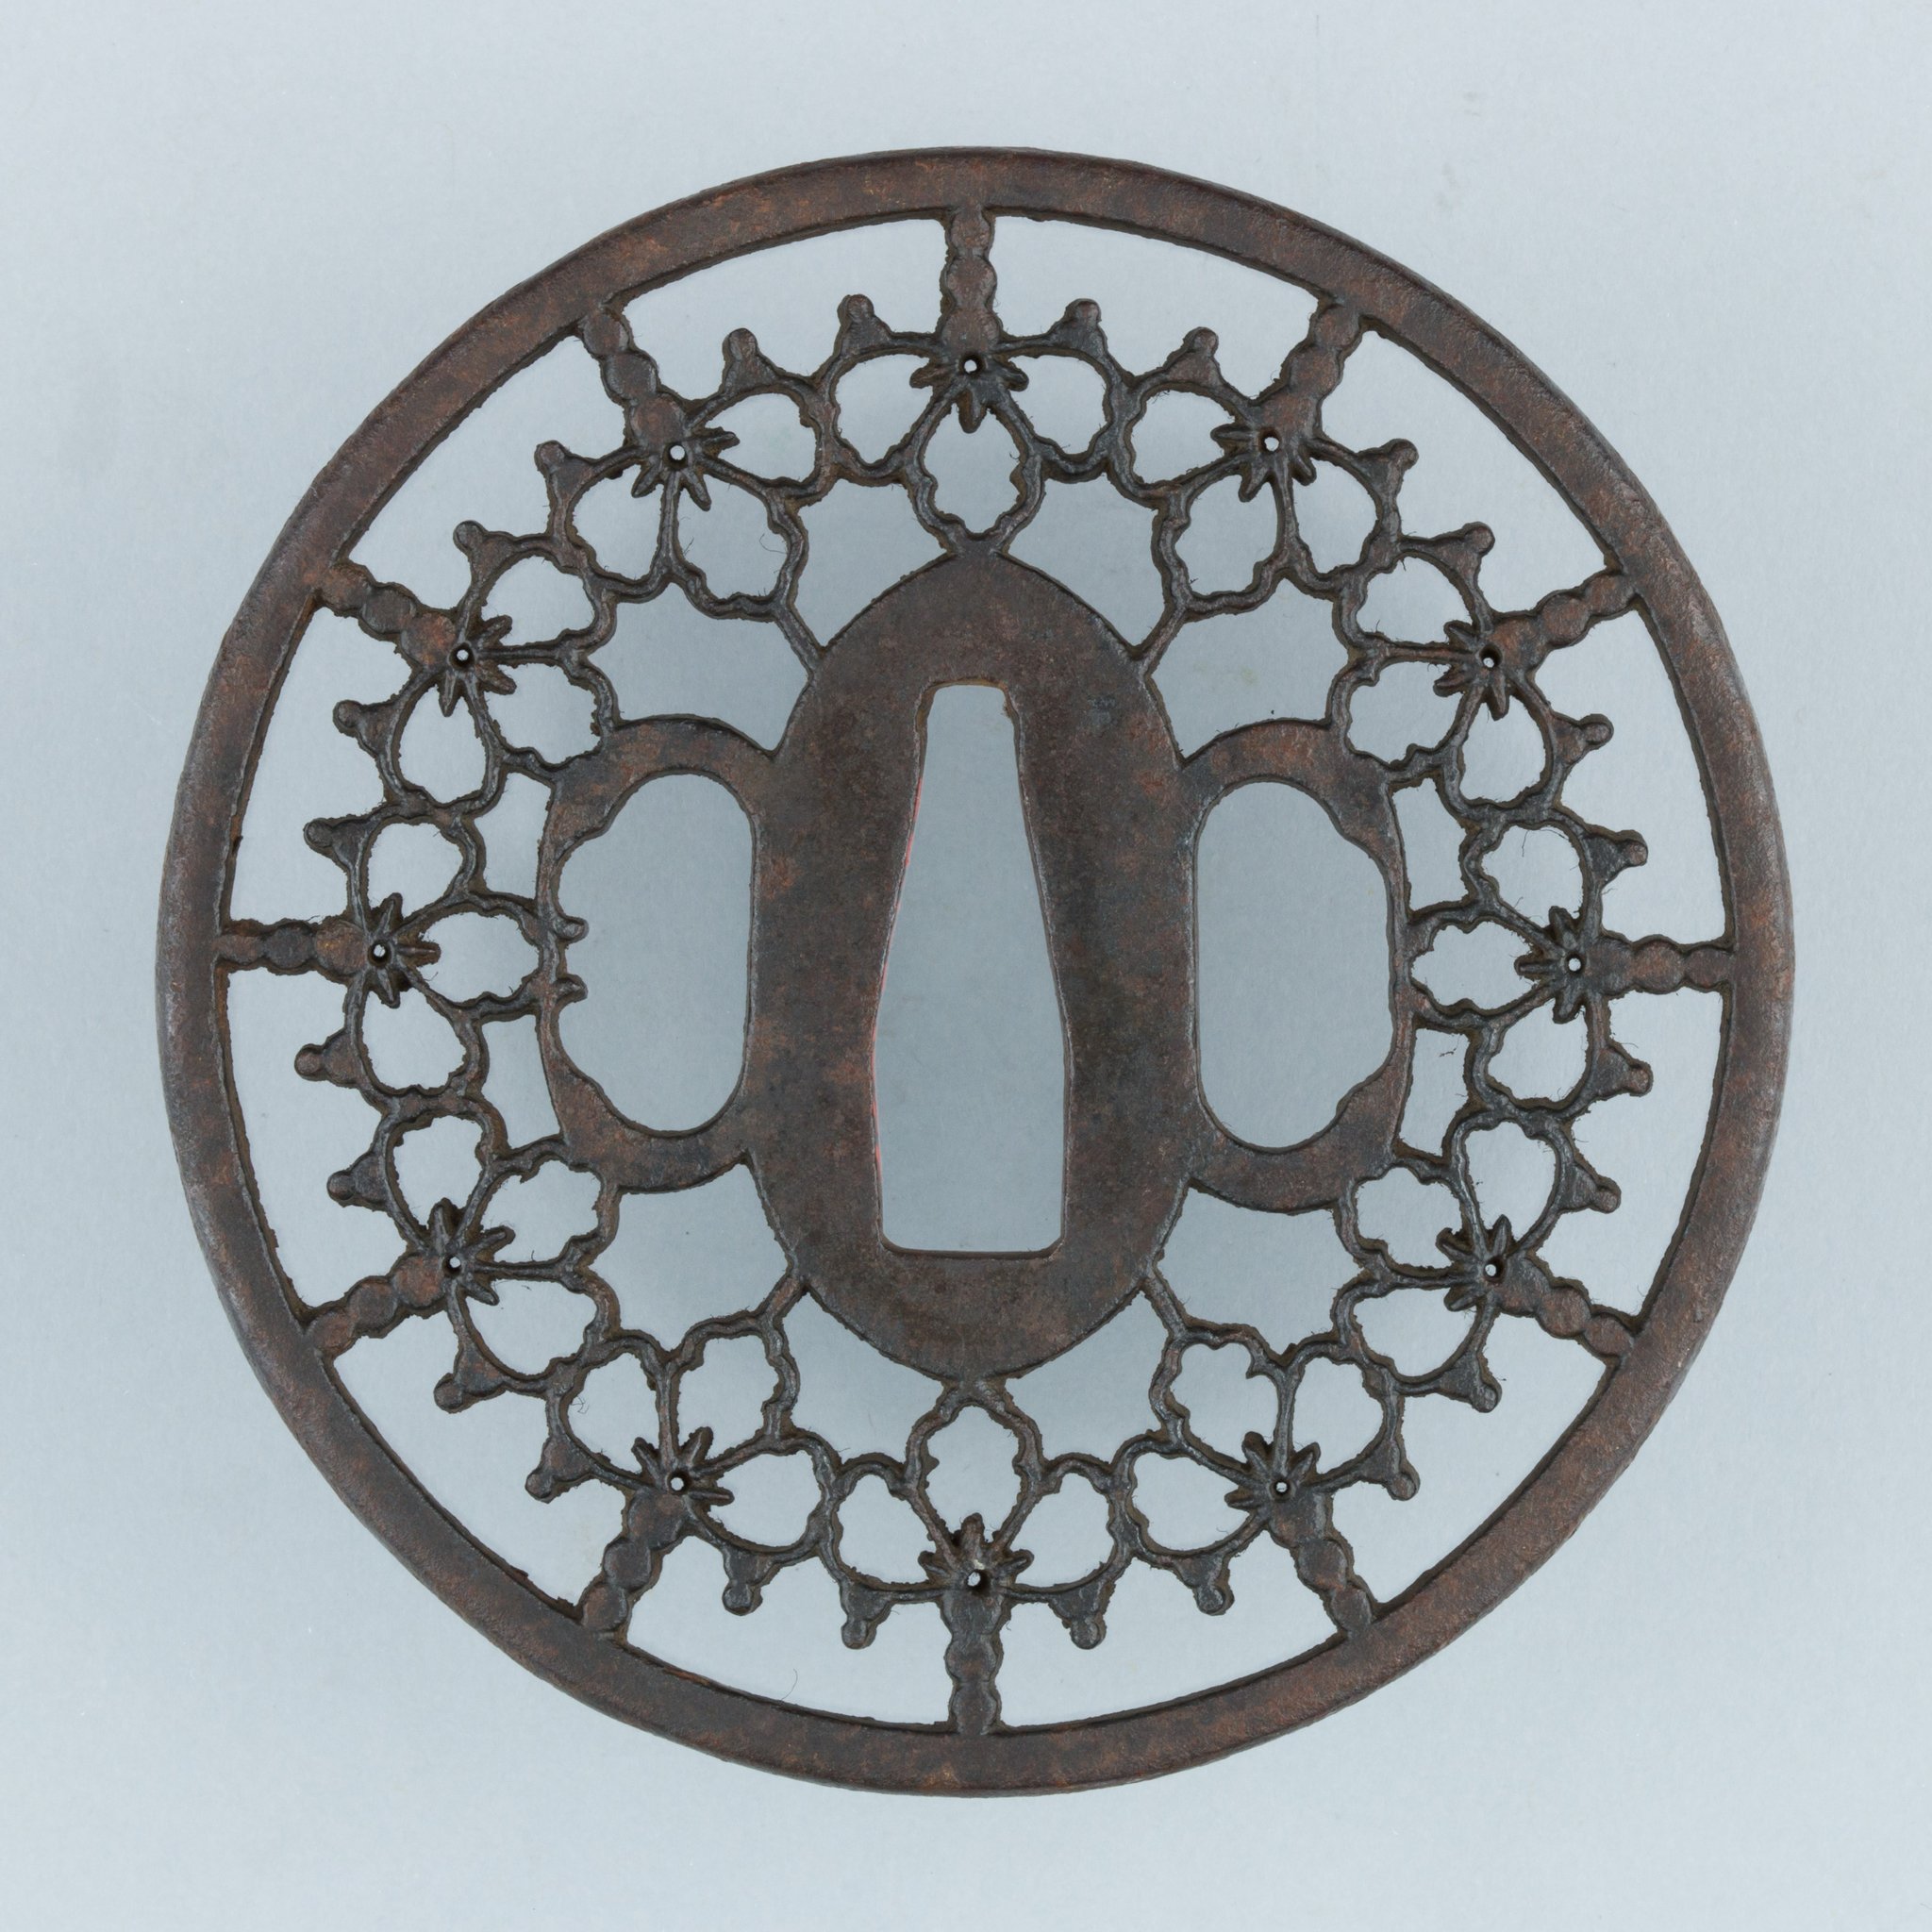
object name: sword guard tsuba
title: Sword Guard (Tsuba)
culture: japanese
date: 1615-1868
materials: copper, iron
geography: japan